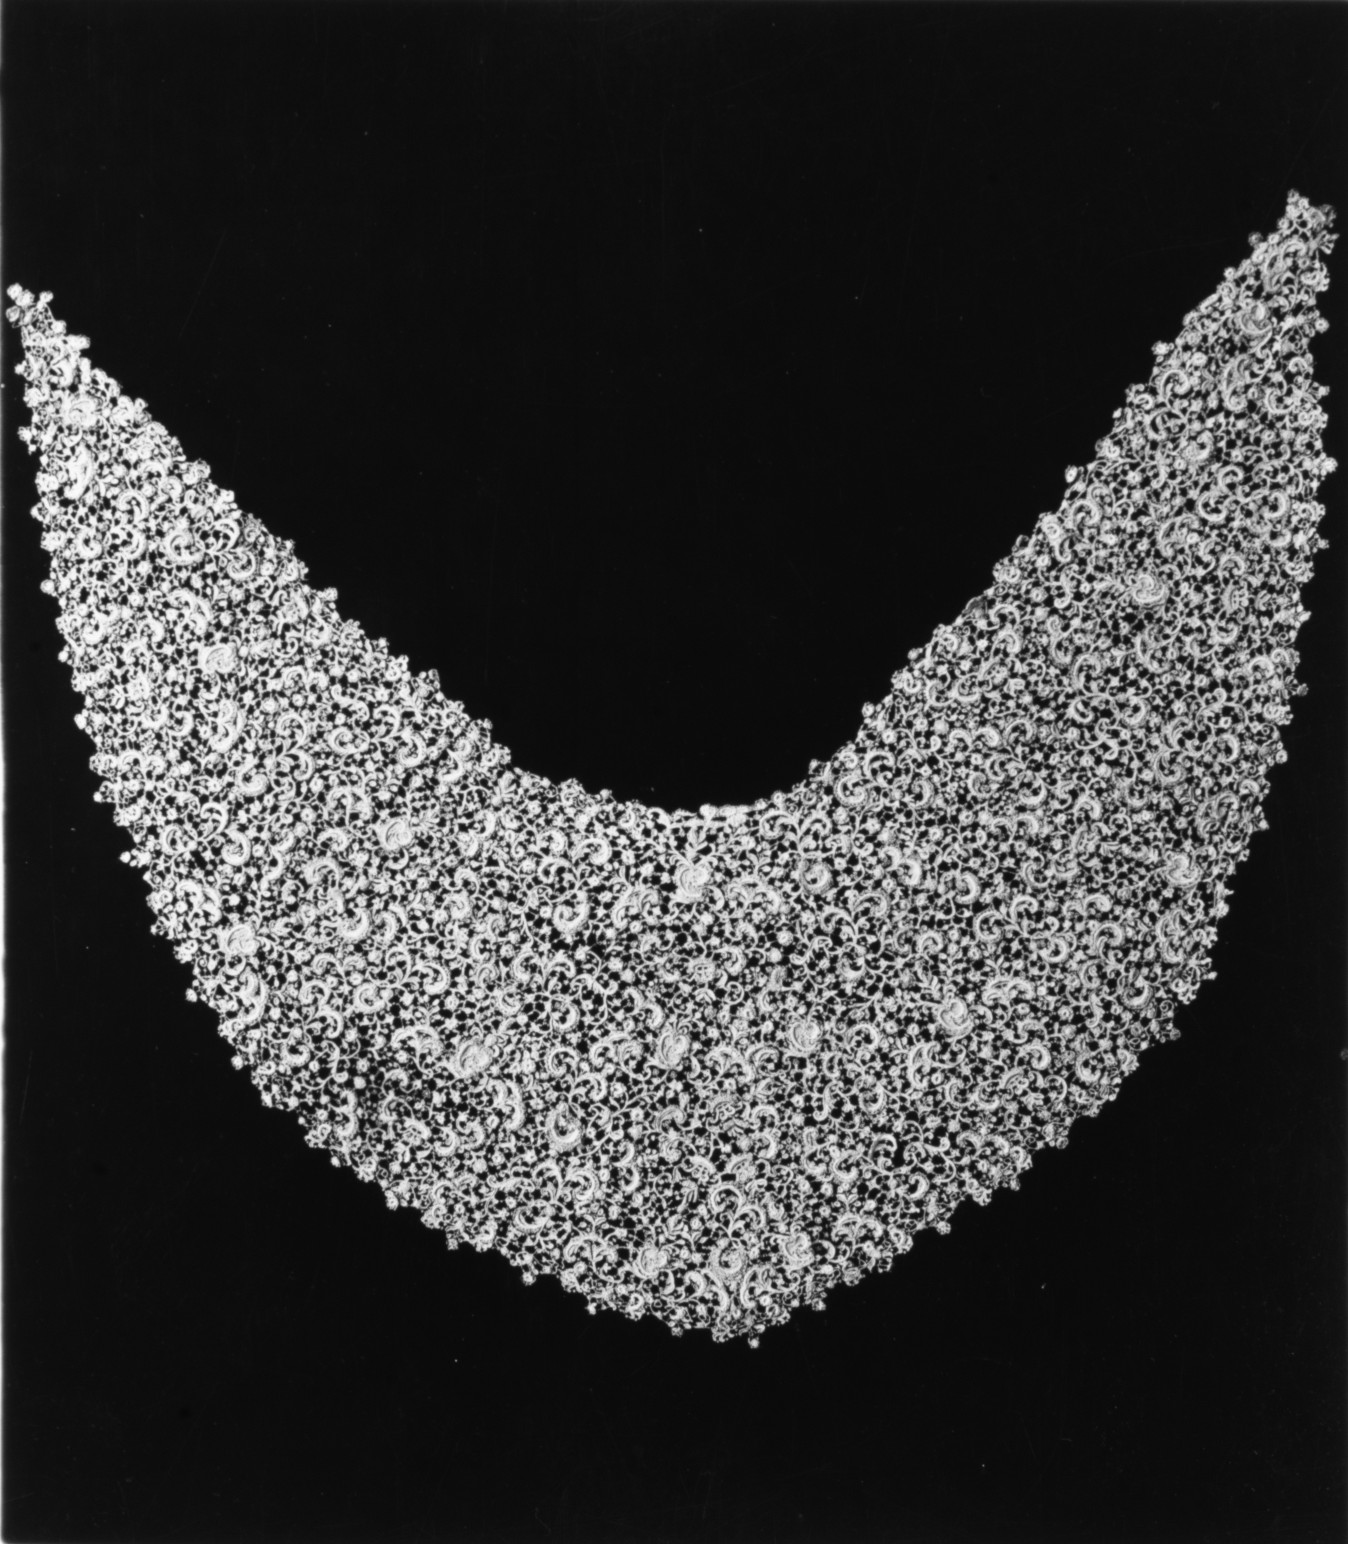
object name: cape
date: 1750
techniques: lace